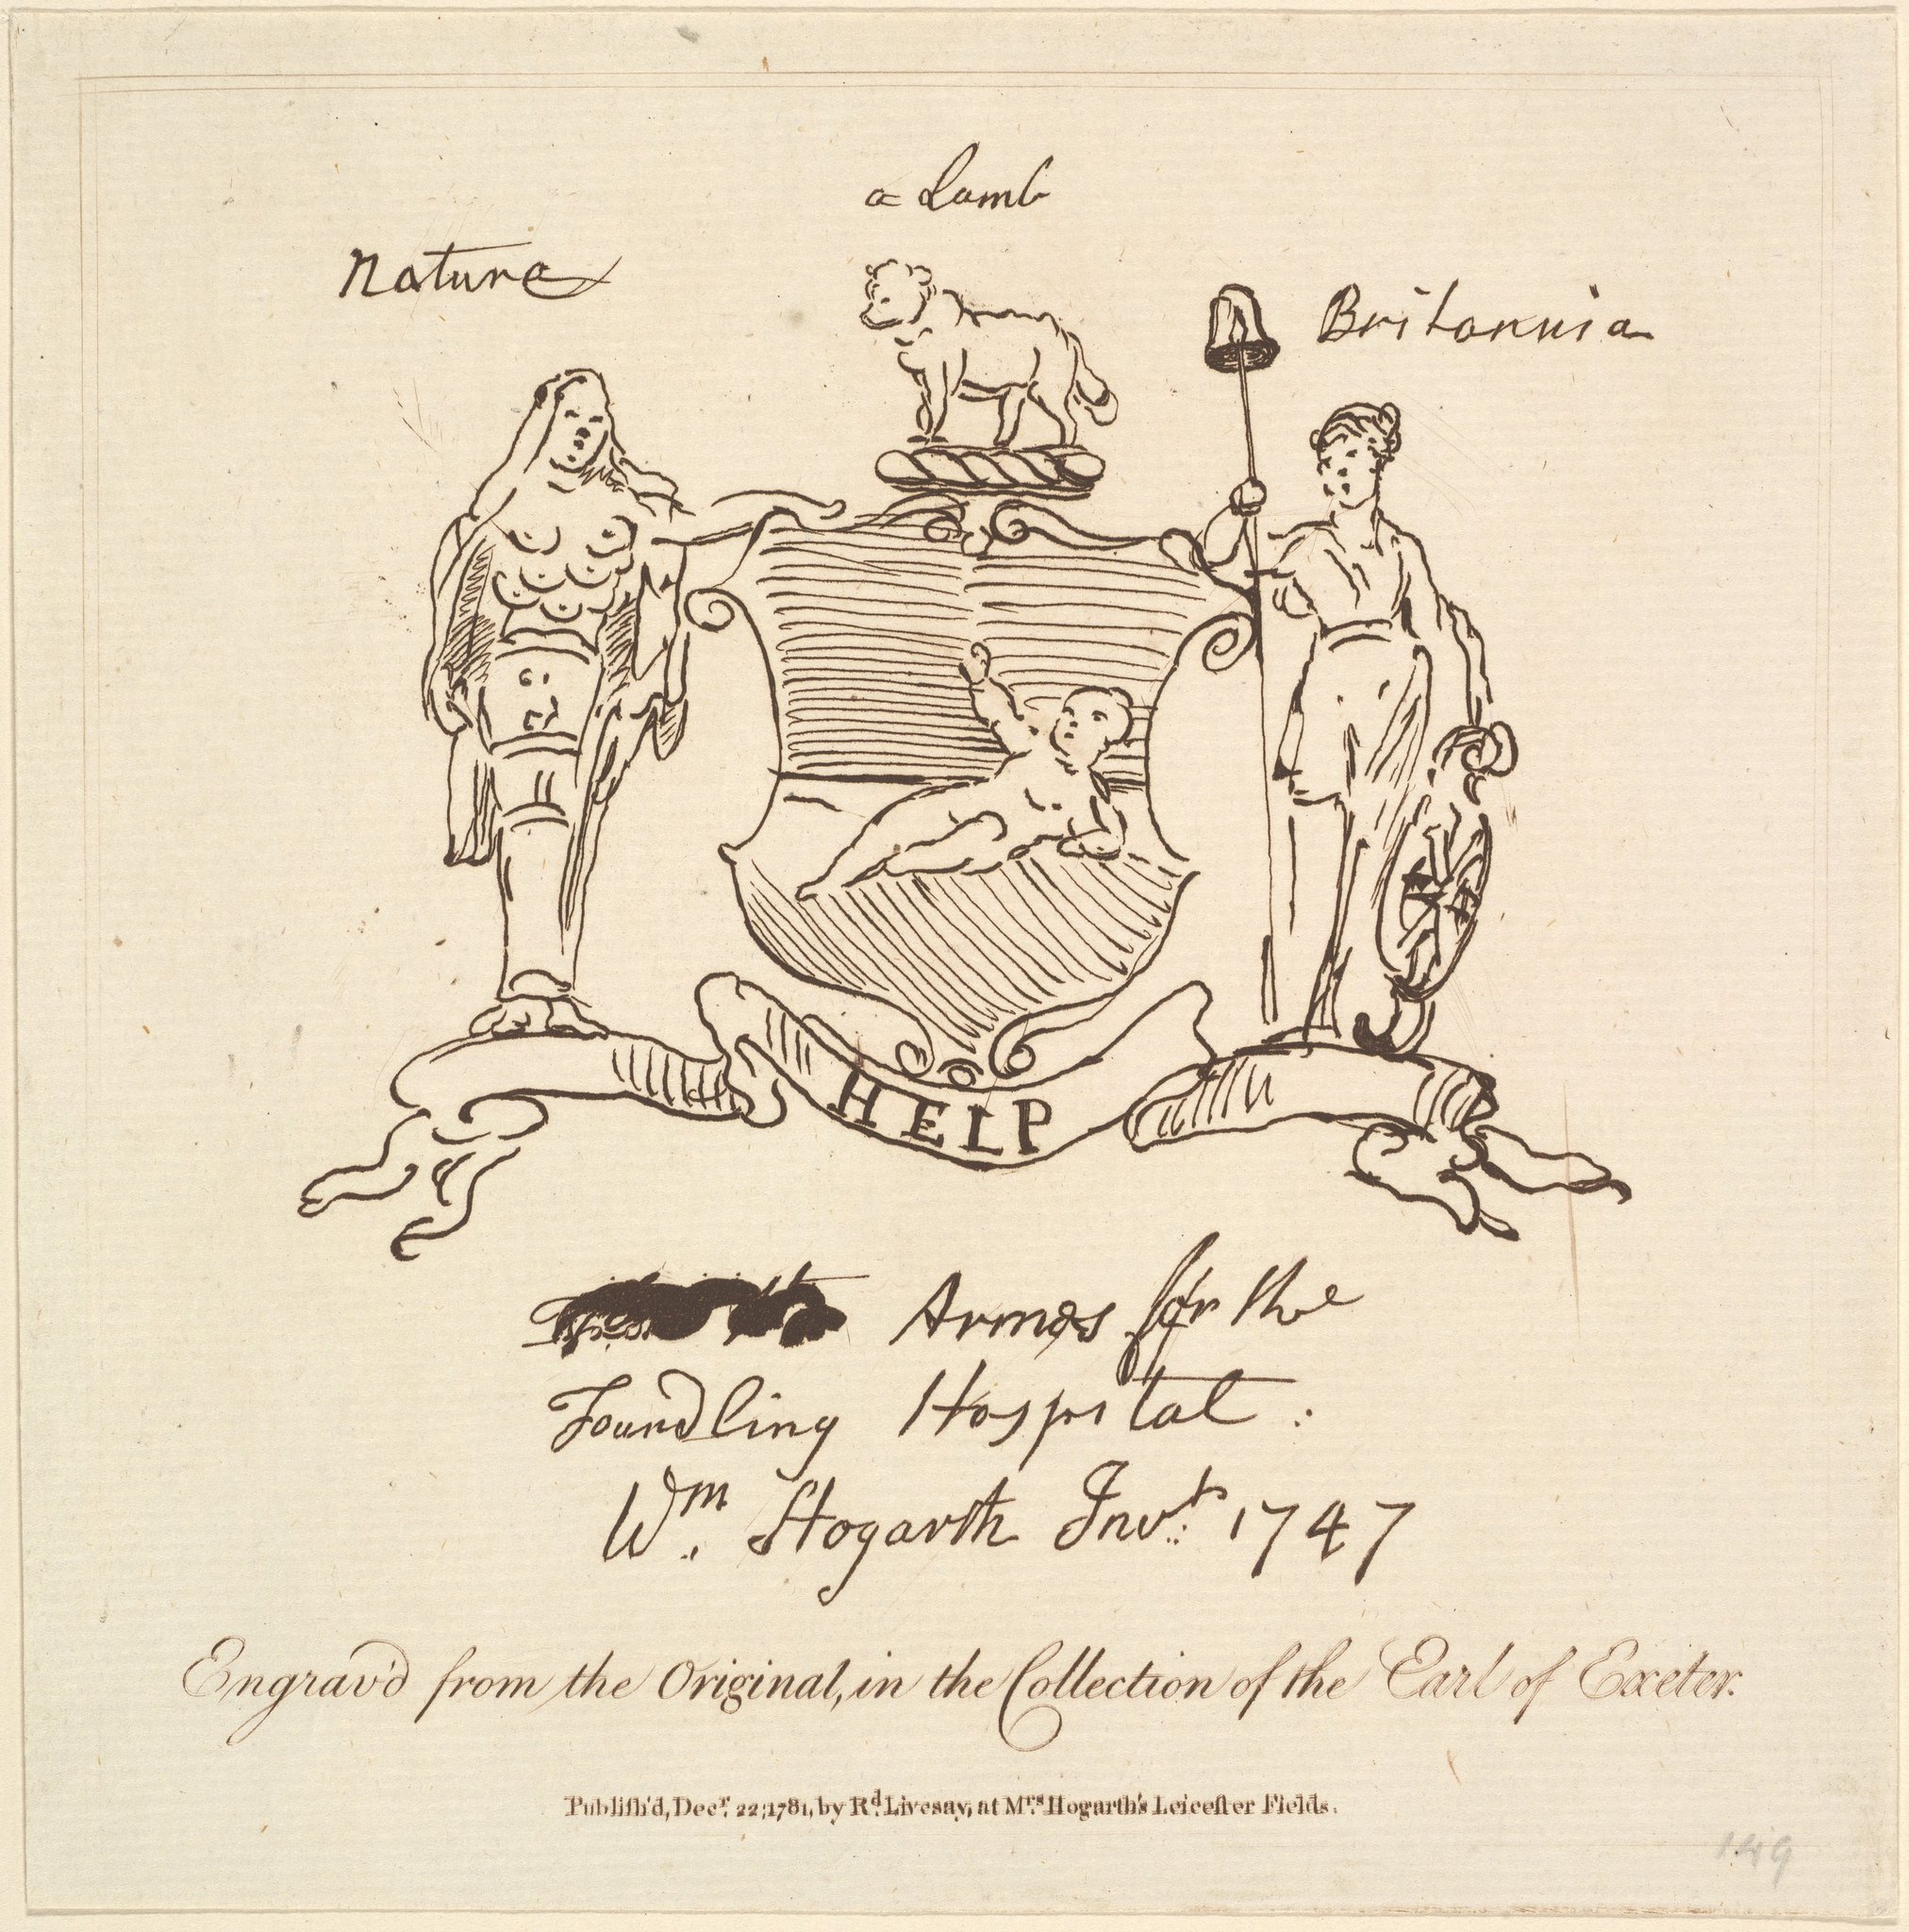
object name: print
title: Arms for the Foundling Hospital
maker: william hogarth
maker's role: artist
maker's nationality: british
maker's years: 1697-1764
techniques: etching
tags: coat of arms